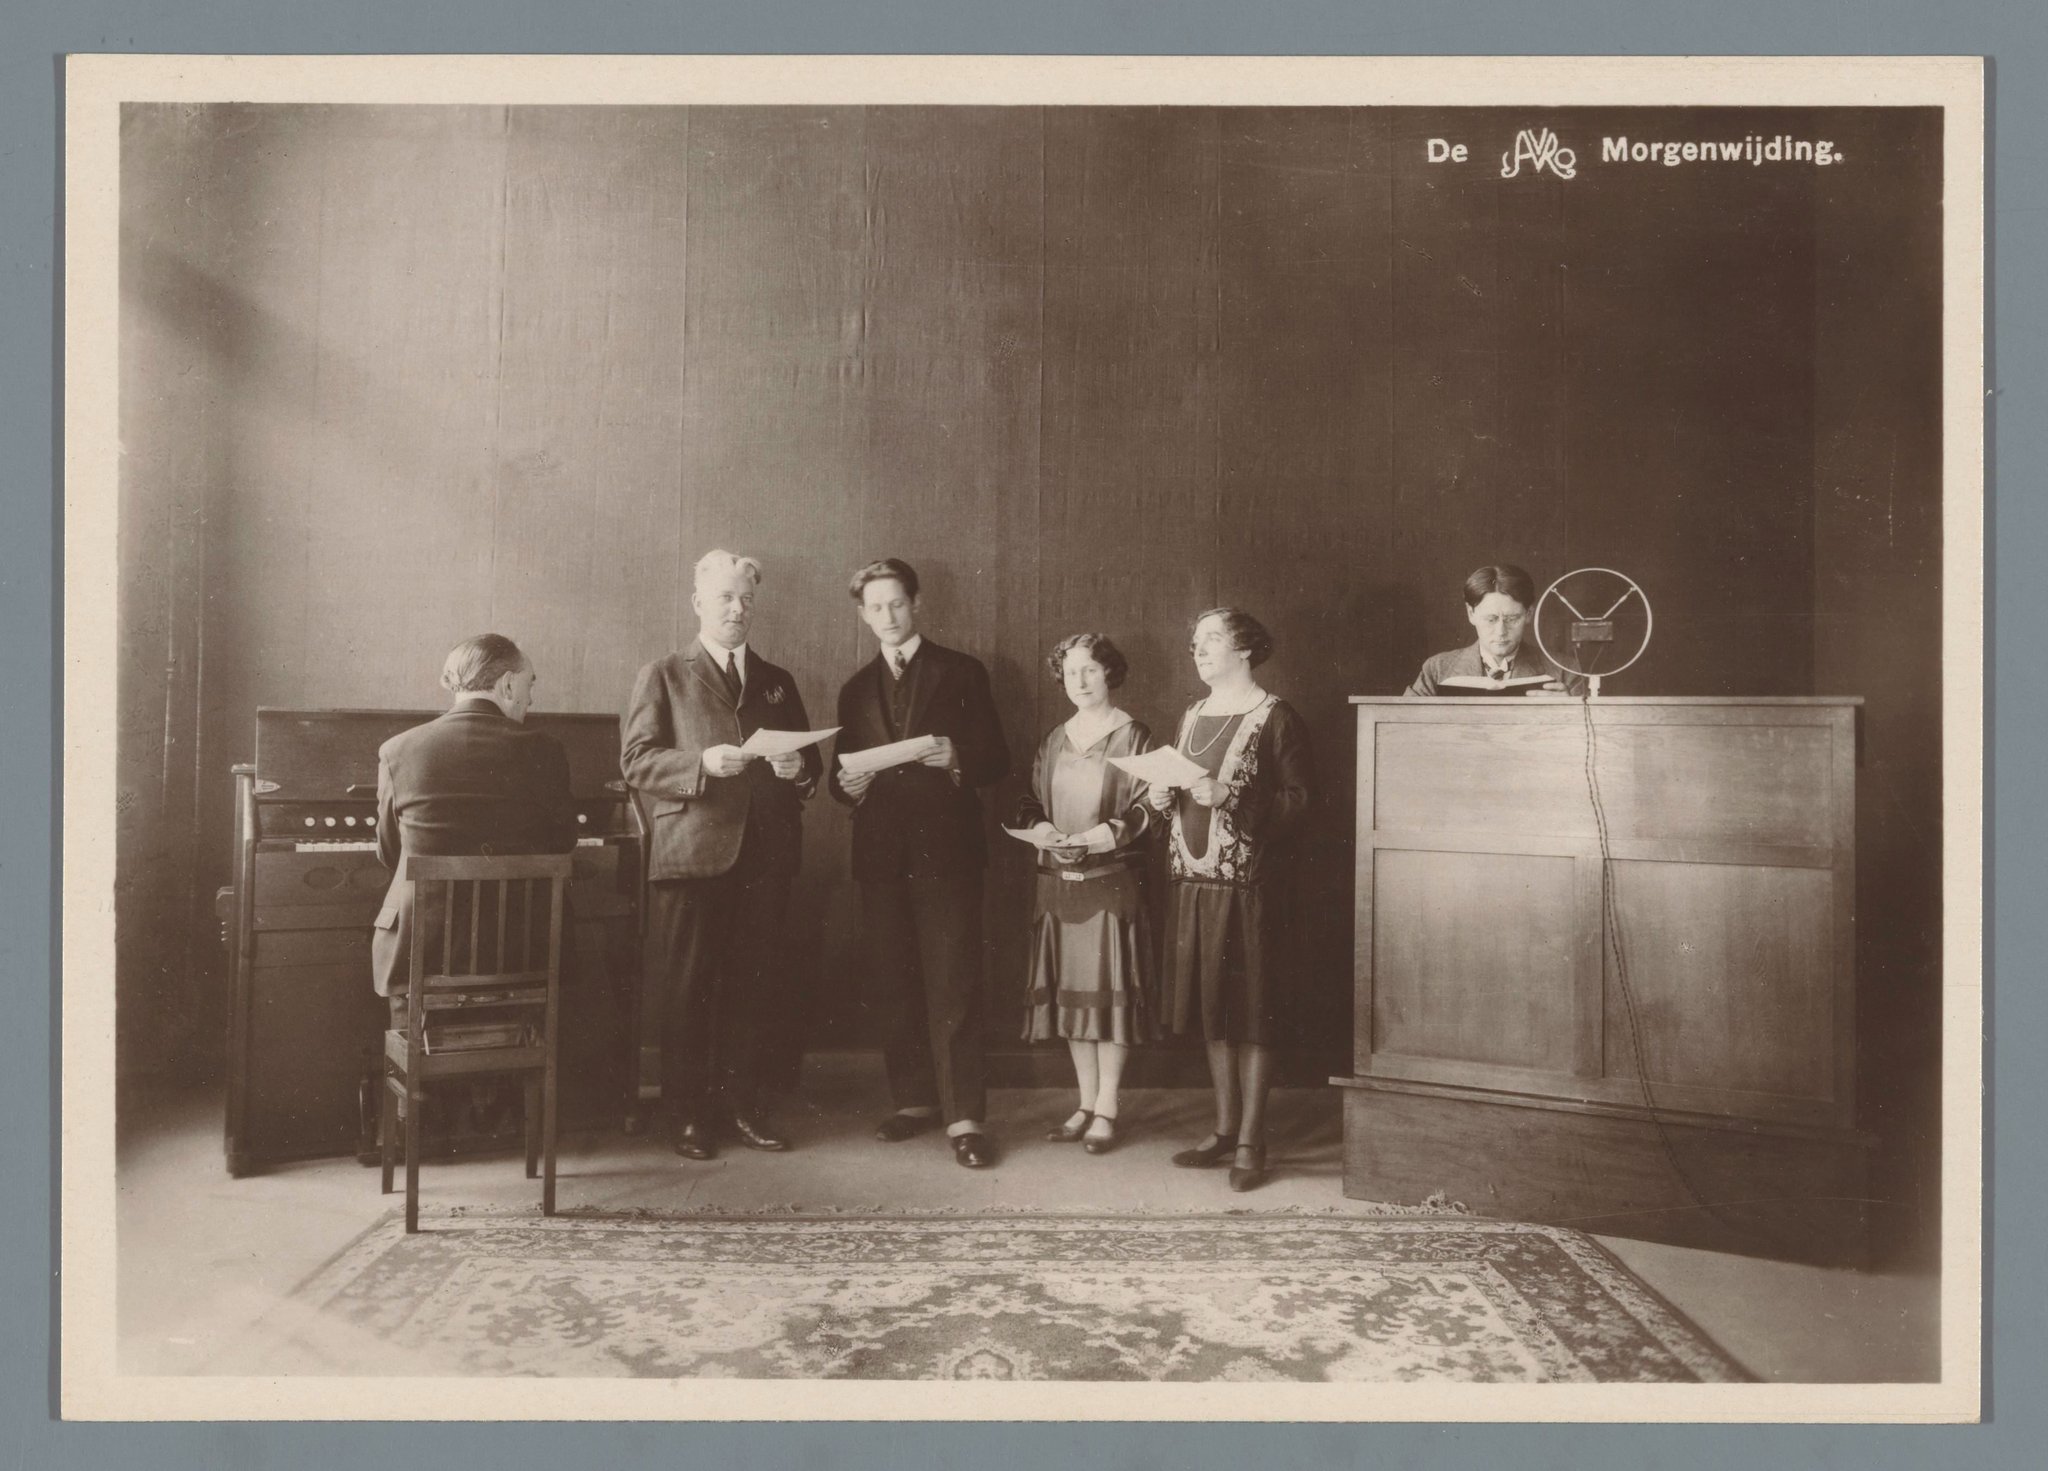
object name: photograph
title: Groepsportret van opname van de Morgenwijding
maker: Anonymous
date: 1928-1945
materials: paper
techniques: gelatin silver print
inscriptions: number: ‘5’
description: Deze foto maakt deel uit van een omslag met tien foto's.